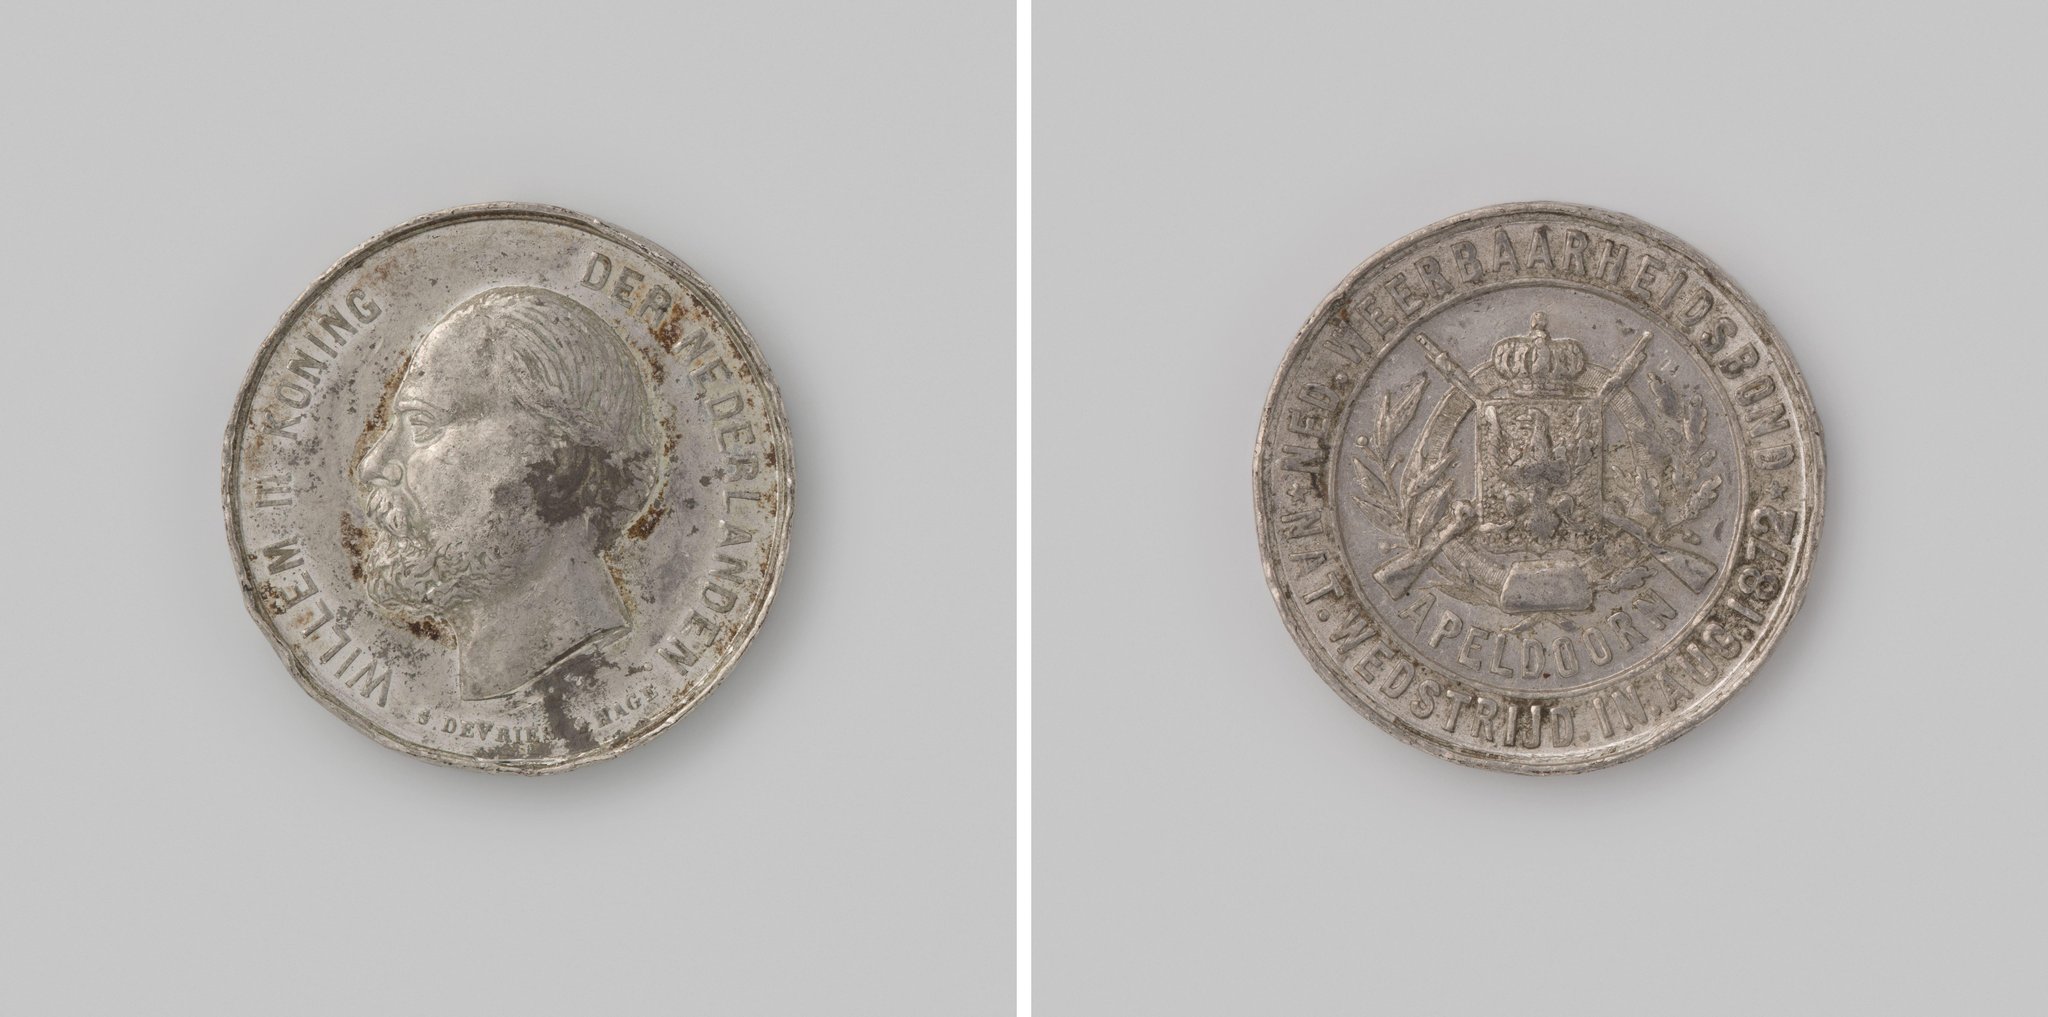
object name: medal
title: Prijspenning van de Nederlandsche Weerbaarheidsbond, Nationale Schietwedstrijd te Apeldoorn, 1872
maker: Anonymous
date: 1872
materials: metal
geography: apeldoorn